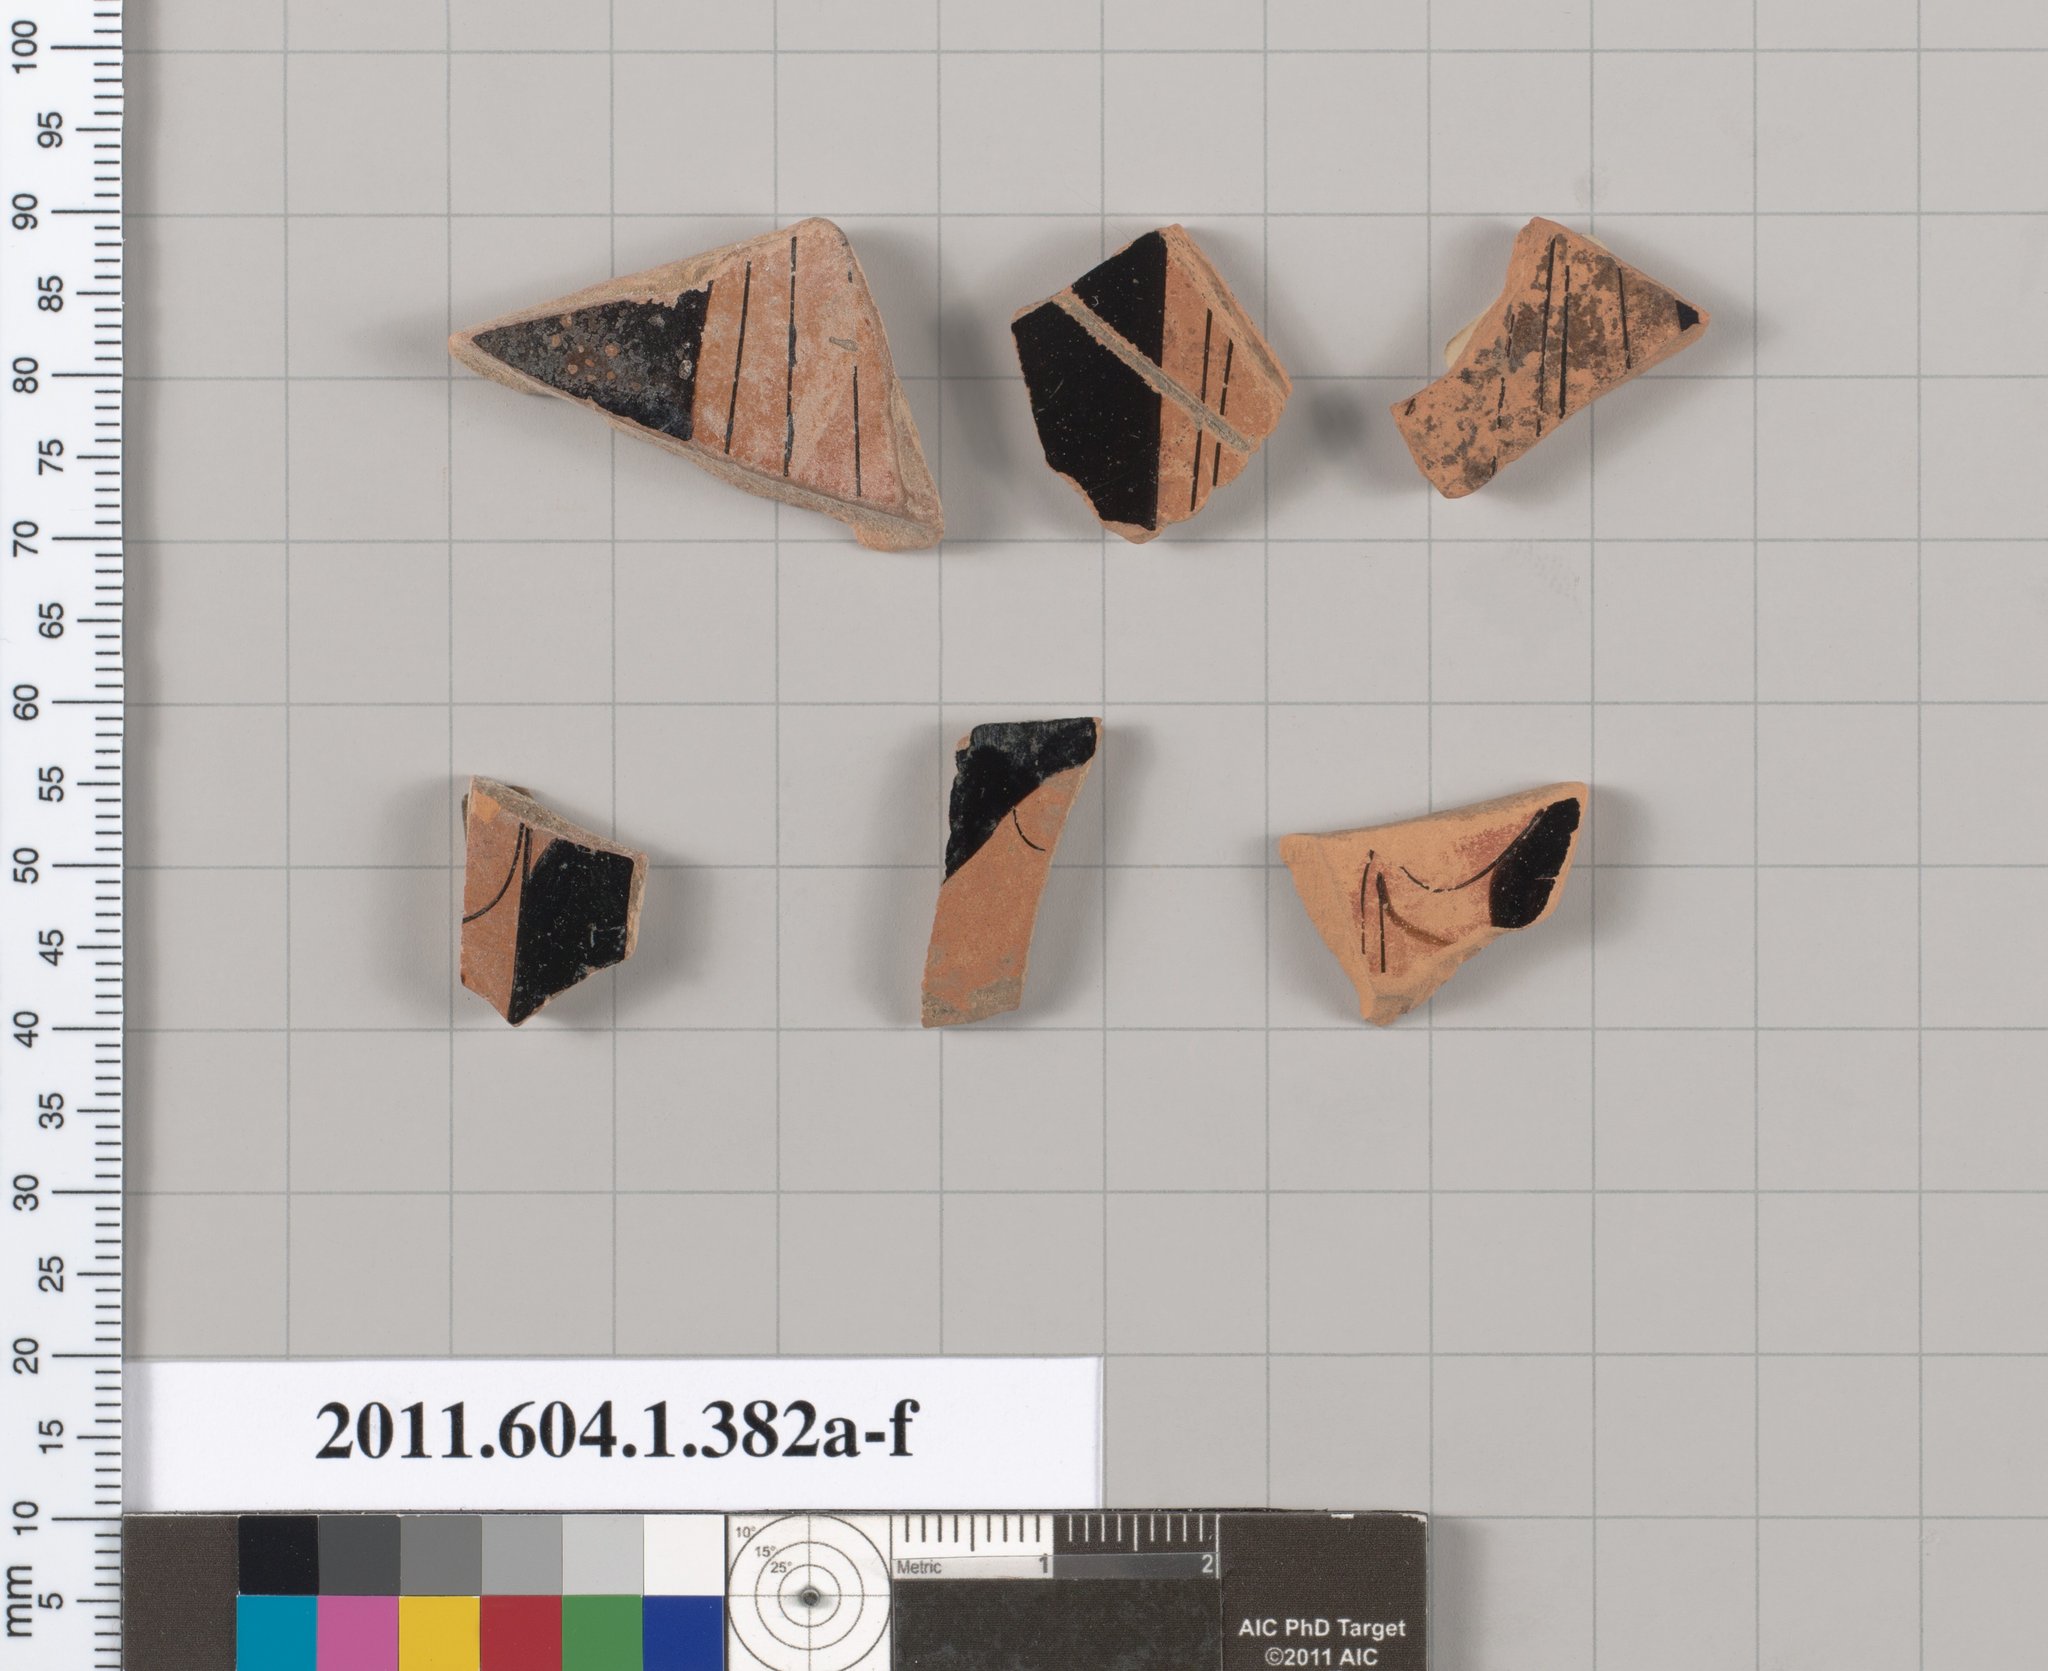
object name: kylix fragment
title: Terracotta fragments of kylikes (drinking cups)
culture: greek, attic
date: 475-451 BCE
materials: terracotta